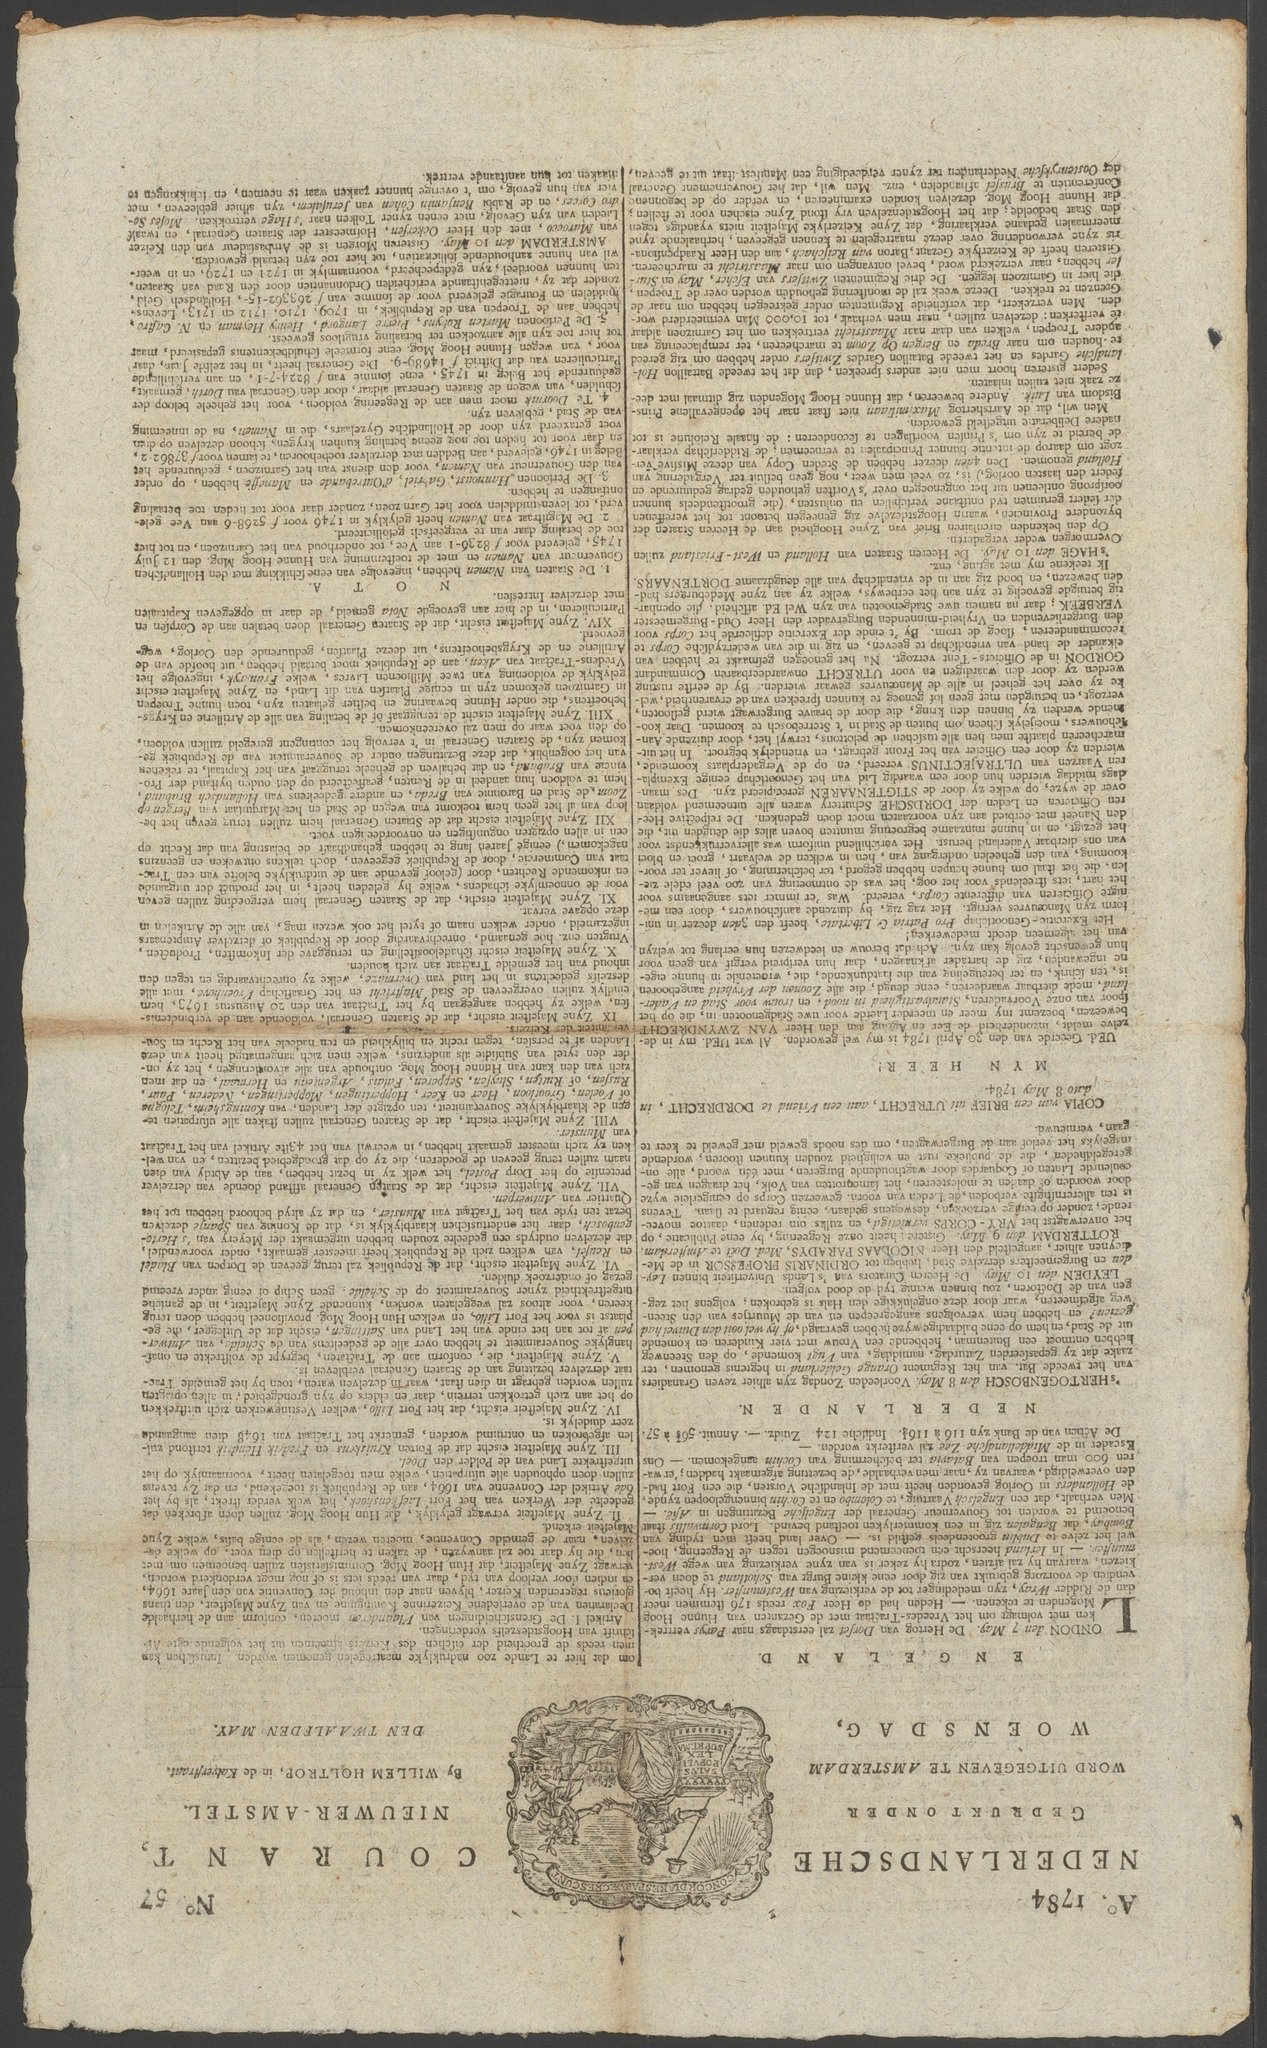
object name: newspaper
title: Nederlandsche Courant, 12 mei 1784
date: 1784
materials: paper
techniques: letterpress printing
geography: amsterdam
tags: newspaper, news-sheet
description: Exemplaar van de krant 'Nederlandsche Courant' van 12 mei 1784. Enkelbladig, beide zijden bedrukt. Bovenaan een vignet met de Vrijheid en Mercurius. Onderwerpsrubrieken binnen de Atlas Zeden en Gewoonten: Regeering, Officieele Nieuwsbladen.